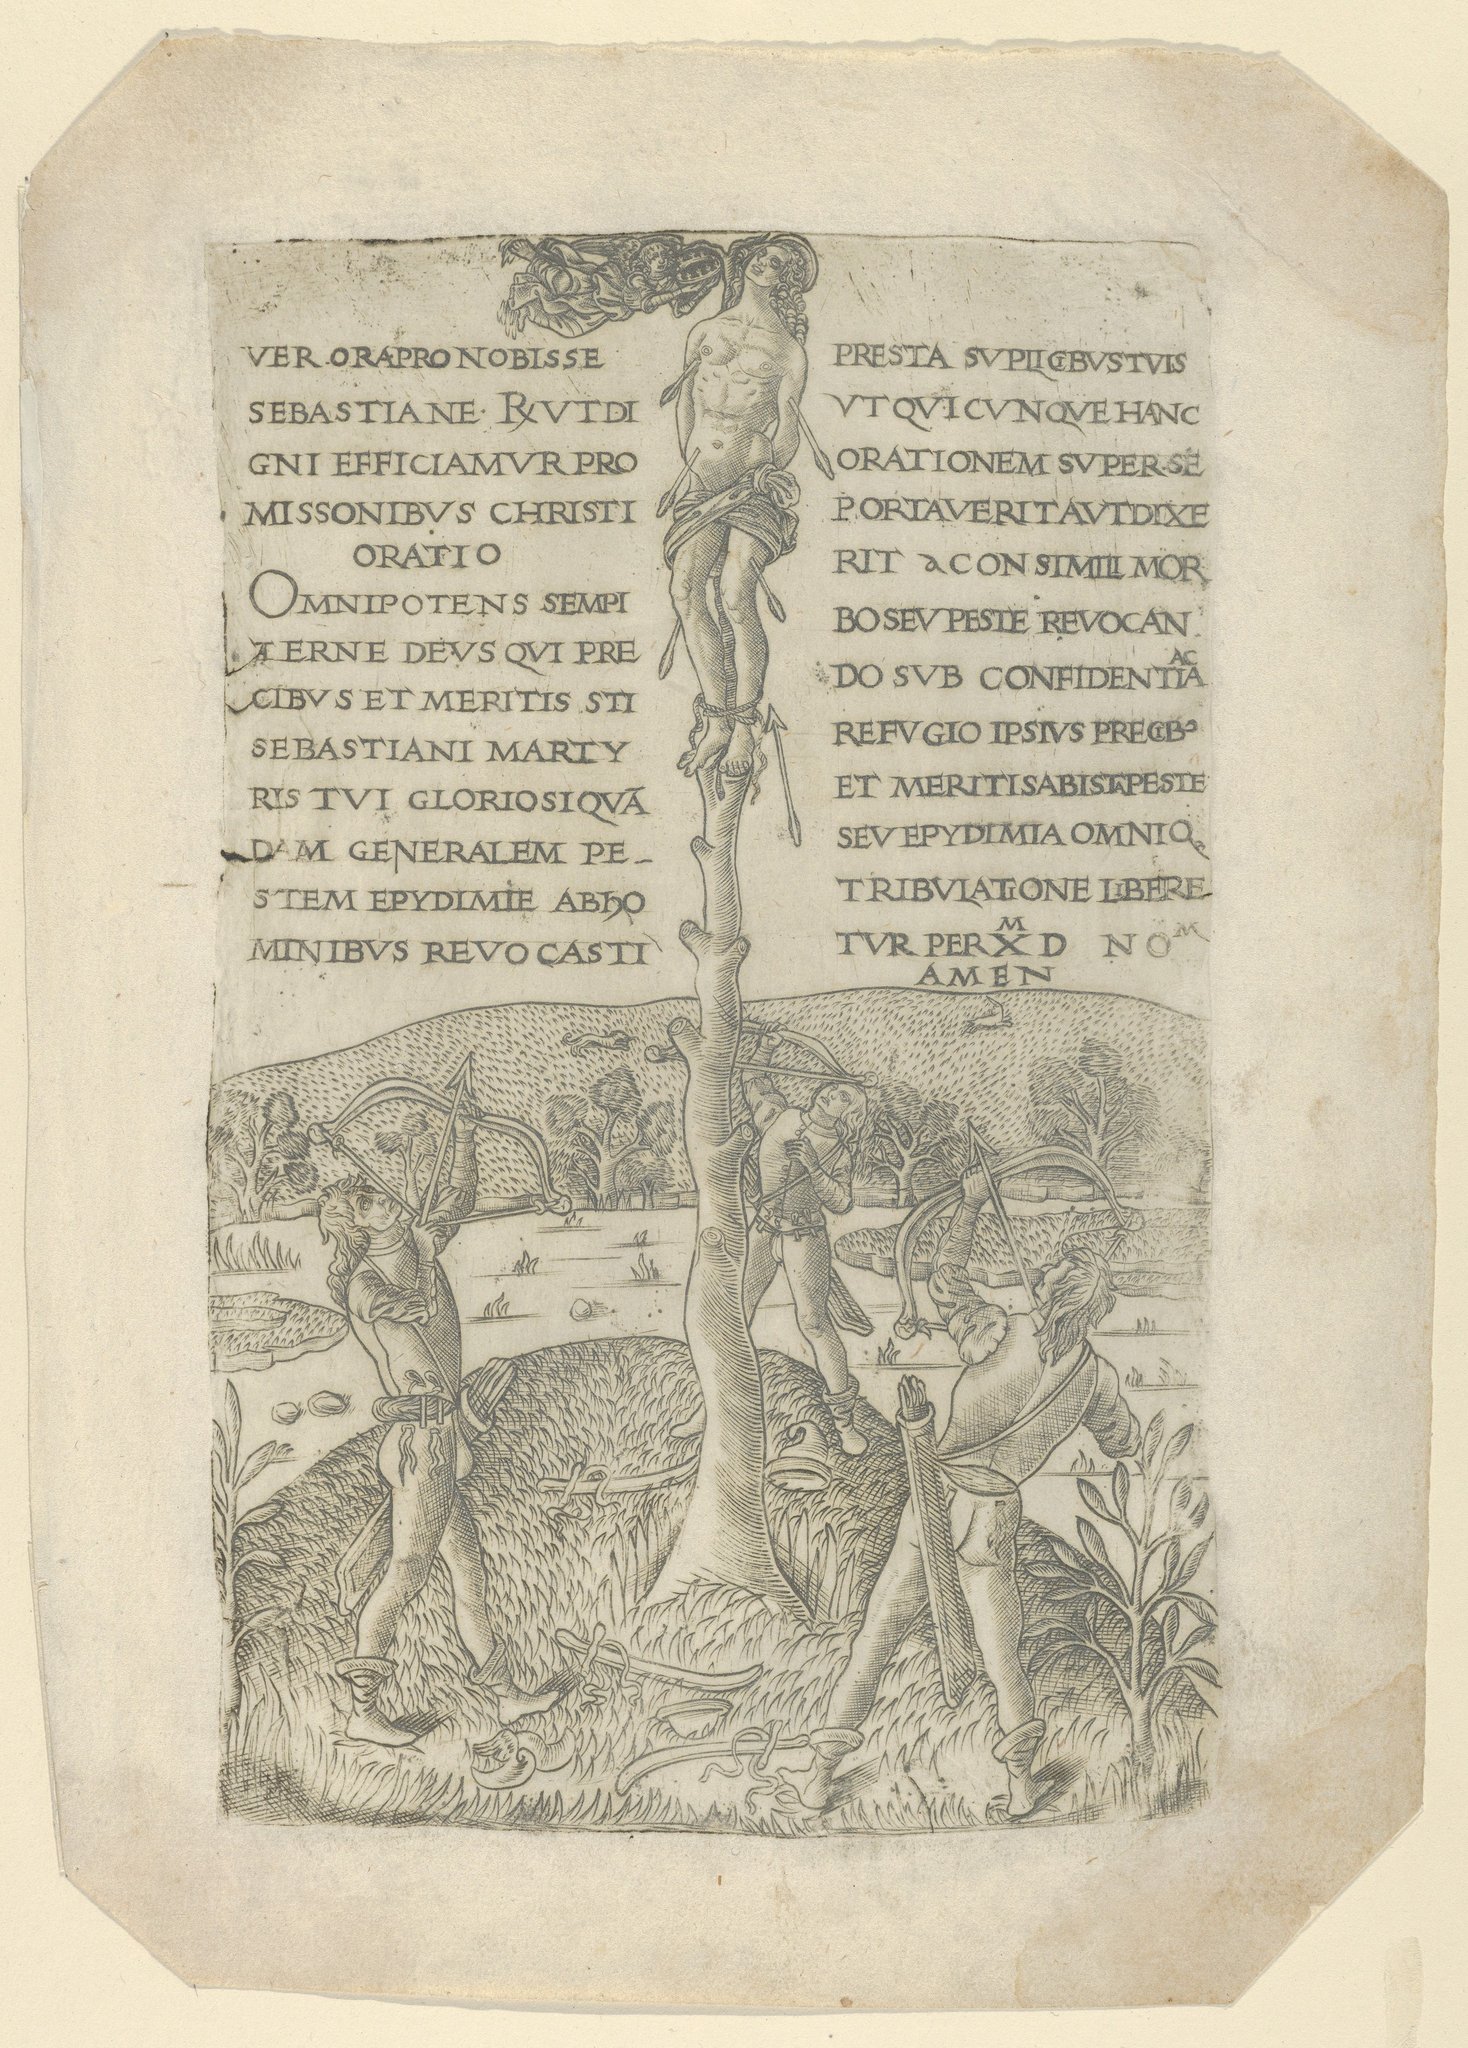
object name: print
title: The Martyrdom of Saint Sebastian, with three archers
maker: anonymous, italian, florentine, 15th century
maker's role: artist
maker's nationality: italian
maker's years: 1400-1500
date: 1480-1490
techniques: engraving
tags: bow and arrow,angels,saints